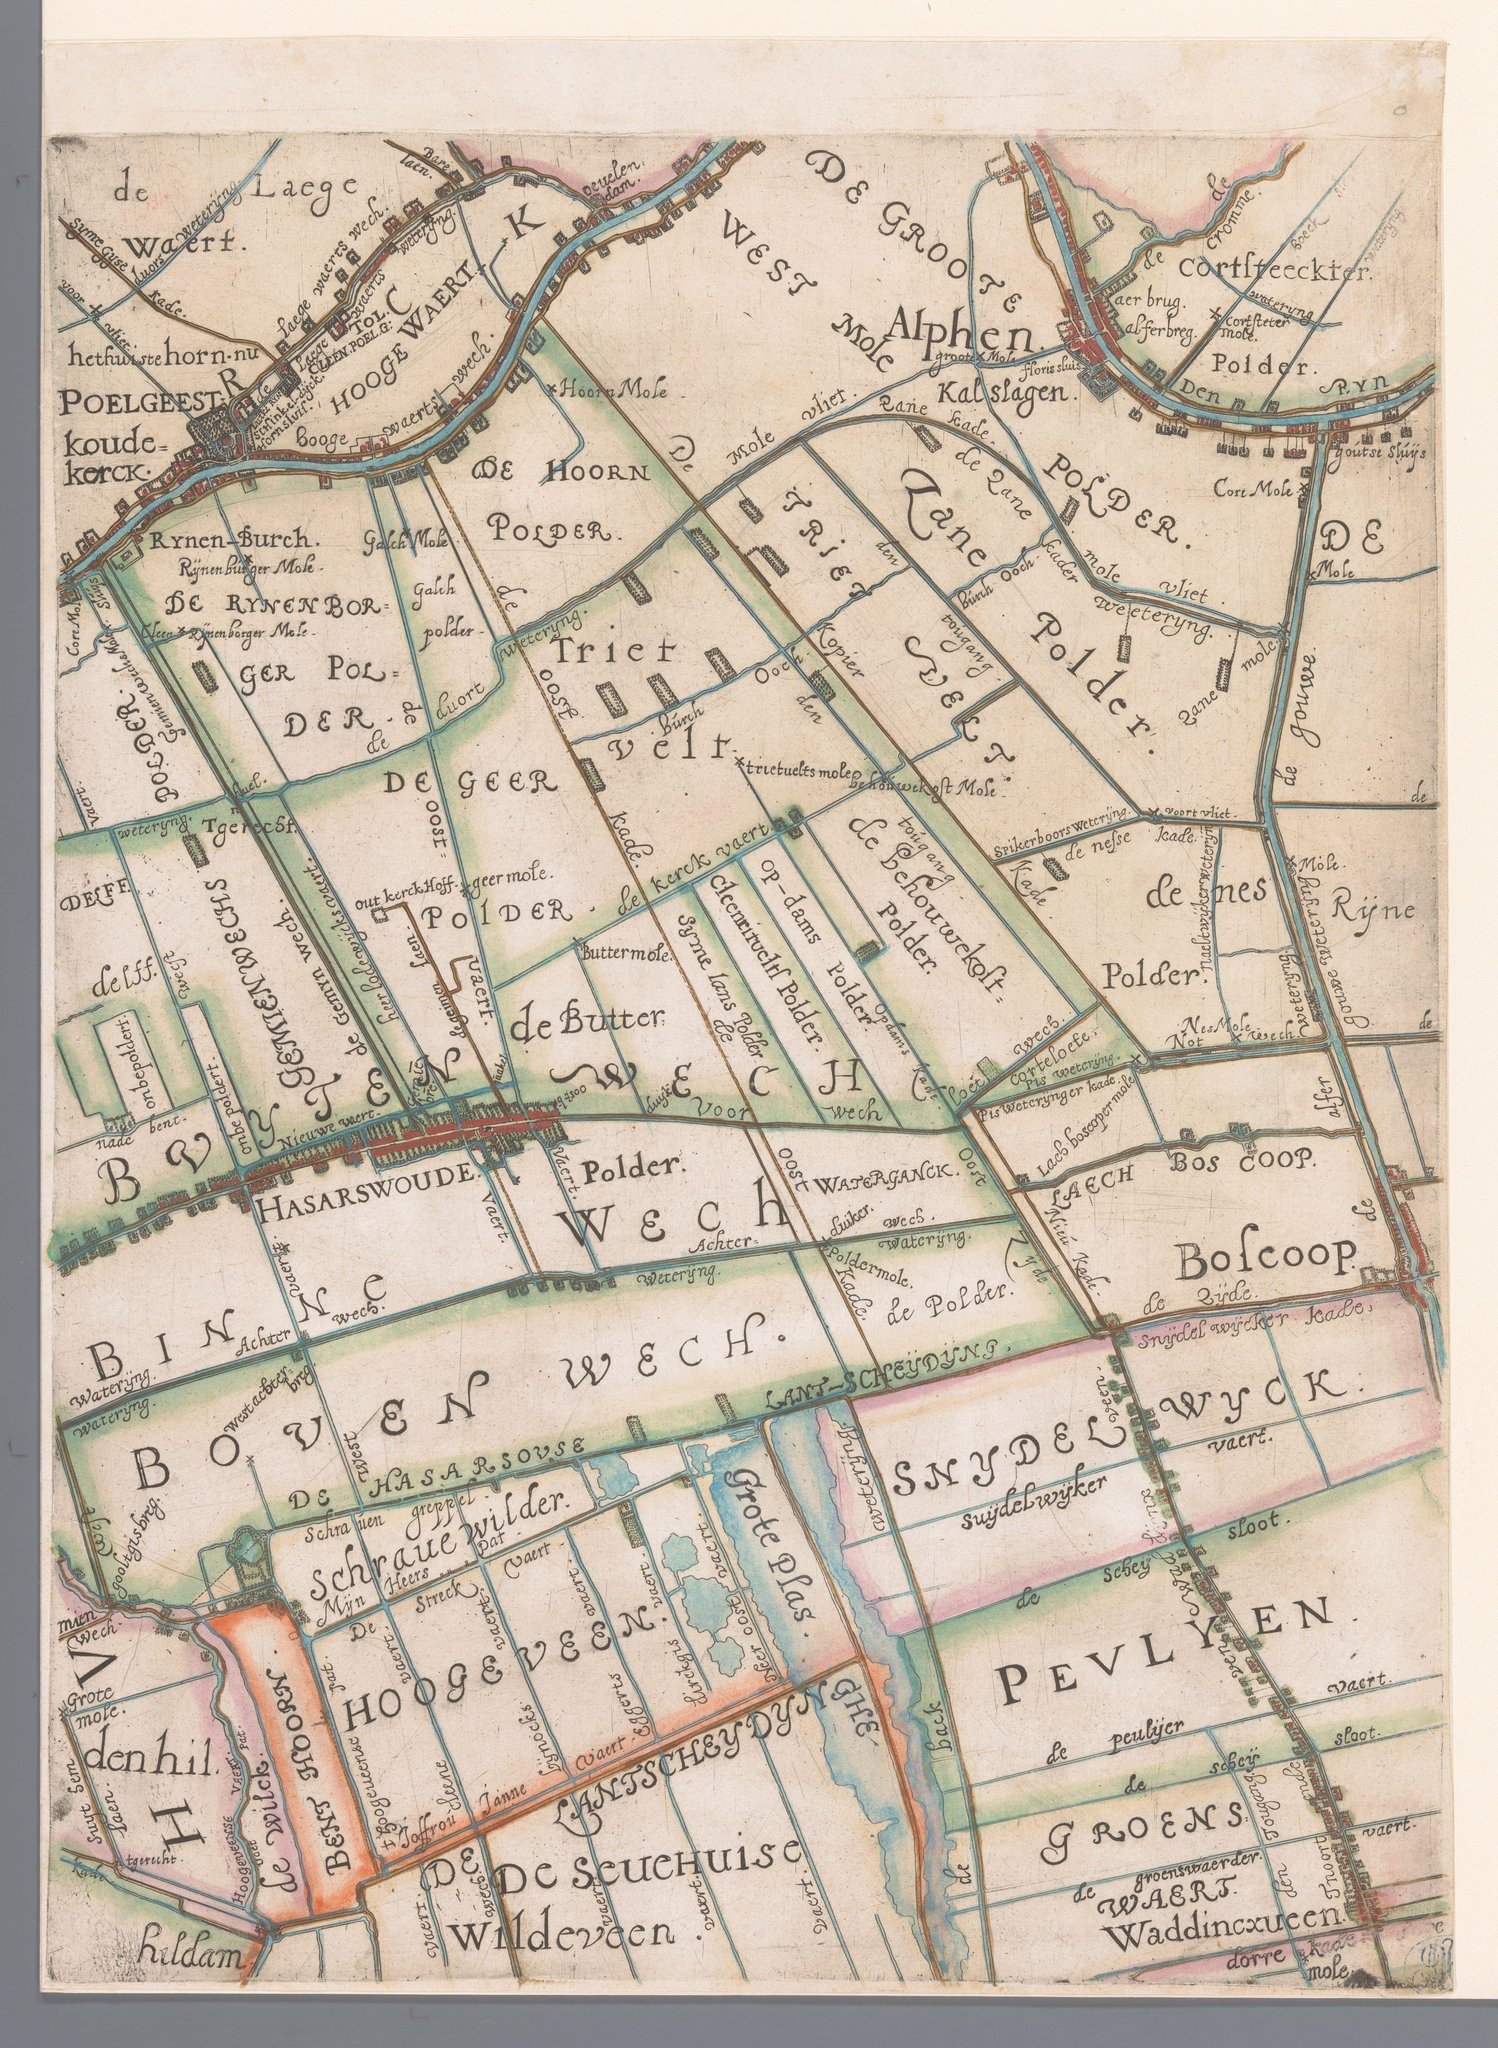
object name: map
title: Deel van een kaart van het Hoogheemraadschap van Rijnland, met Alphen aan den Rijn en omgeving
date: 1615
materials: paper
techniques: engraving, etching, hand coloring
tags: maps of separate countries or regions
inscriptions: collector's mark: Lugt 195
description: Deel van een kaart van Rijnland, bestaande uit 27 delen.